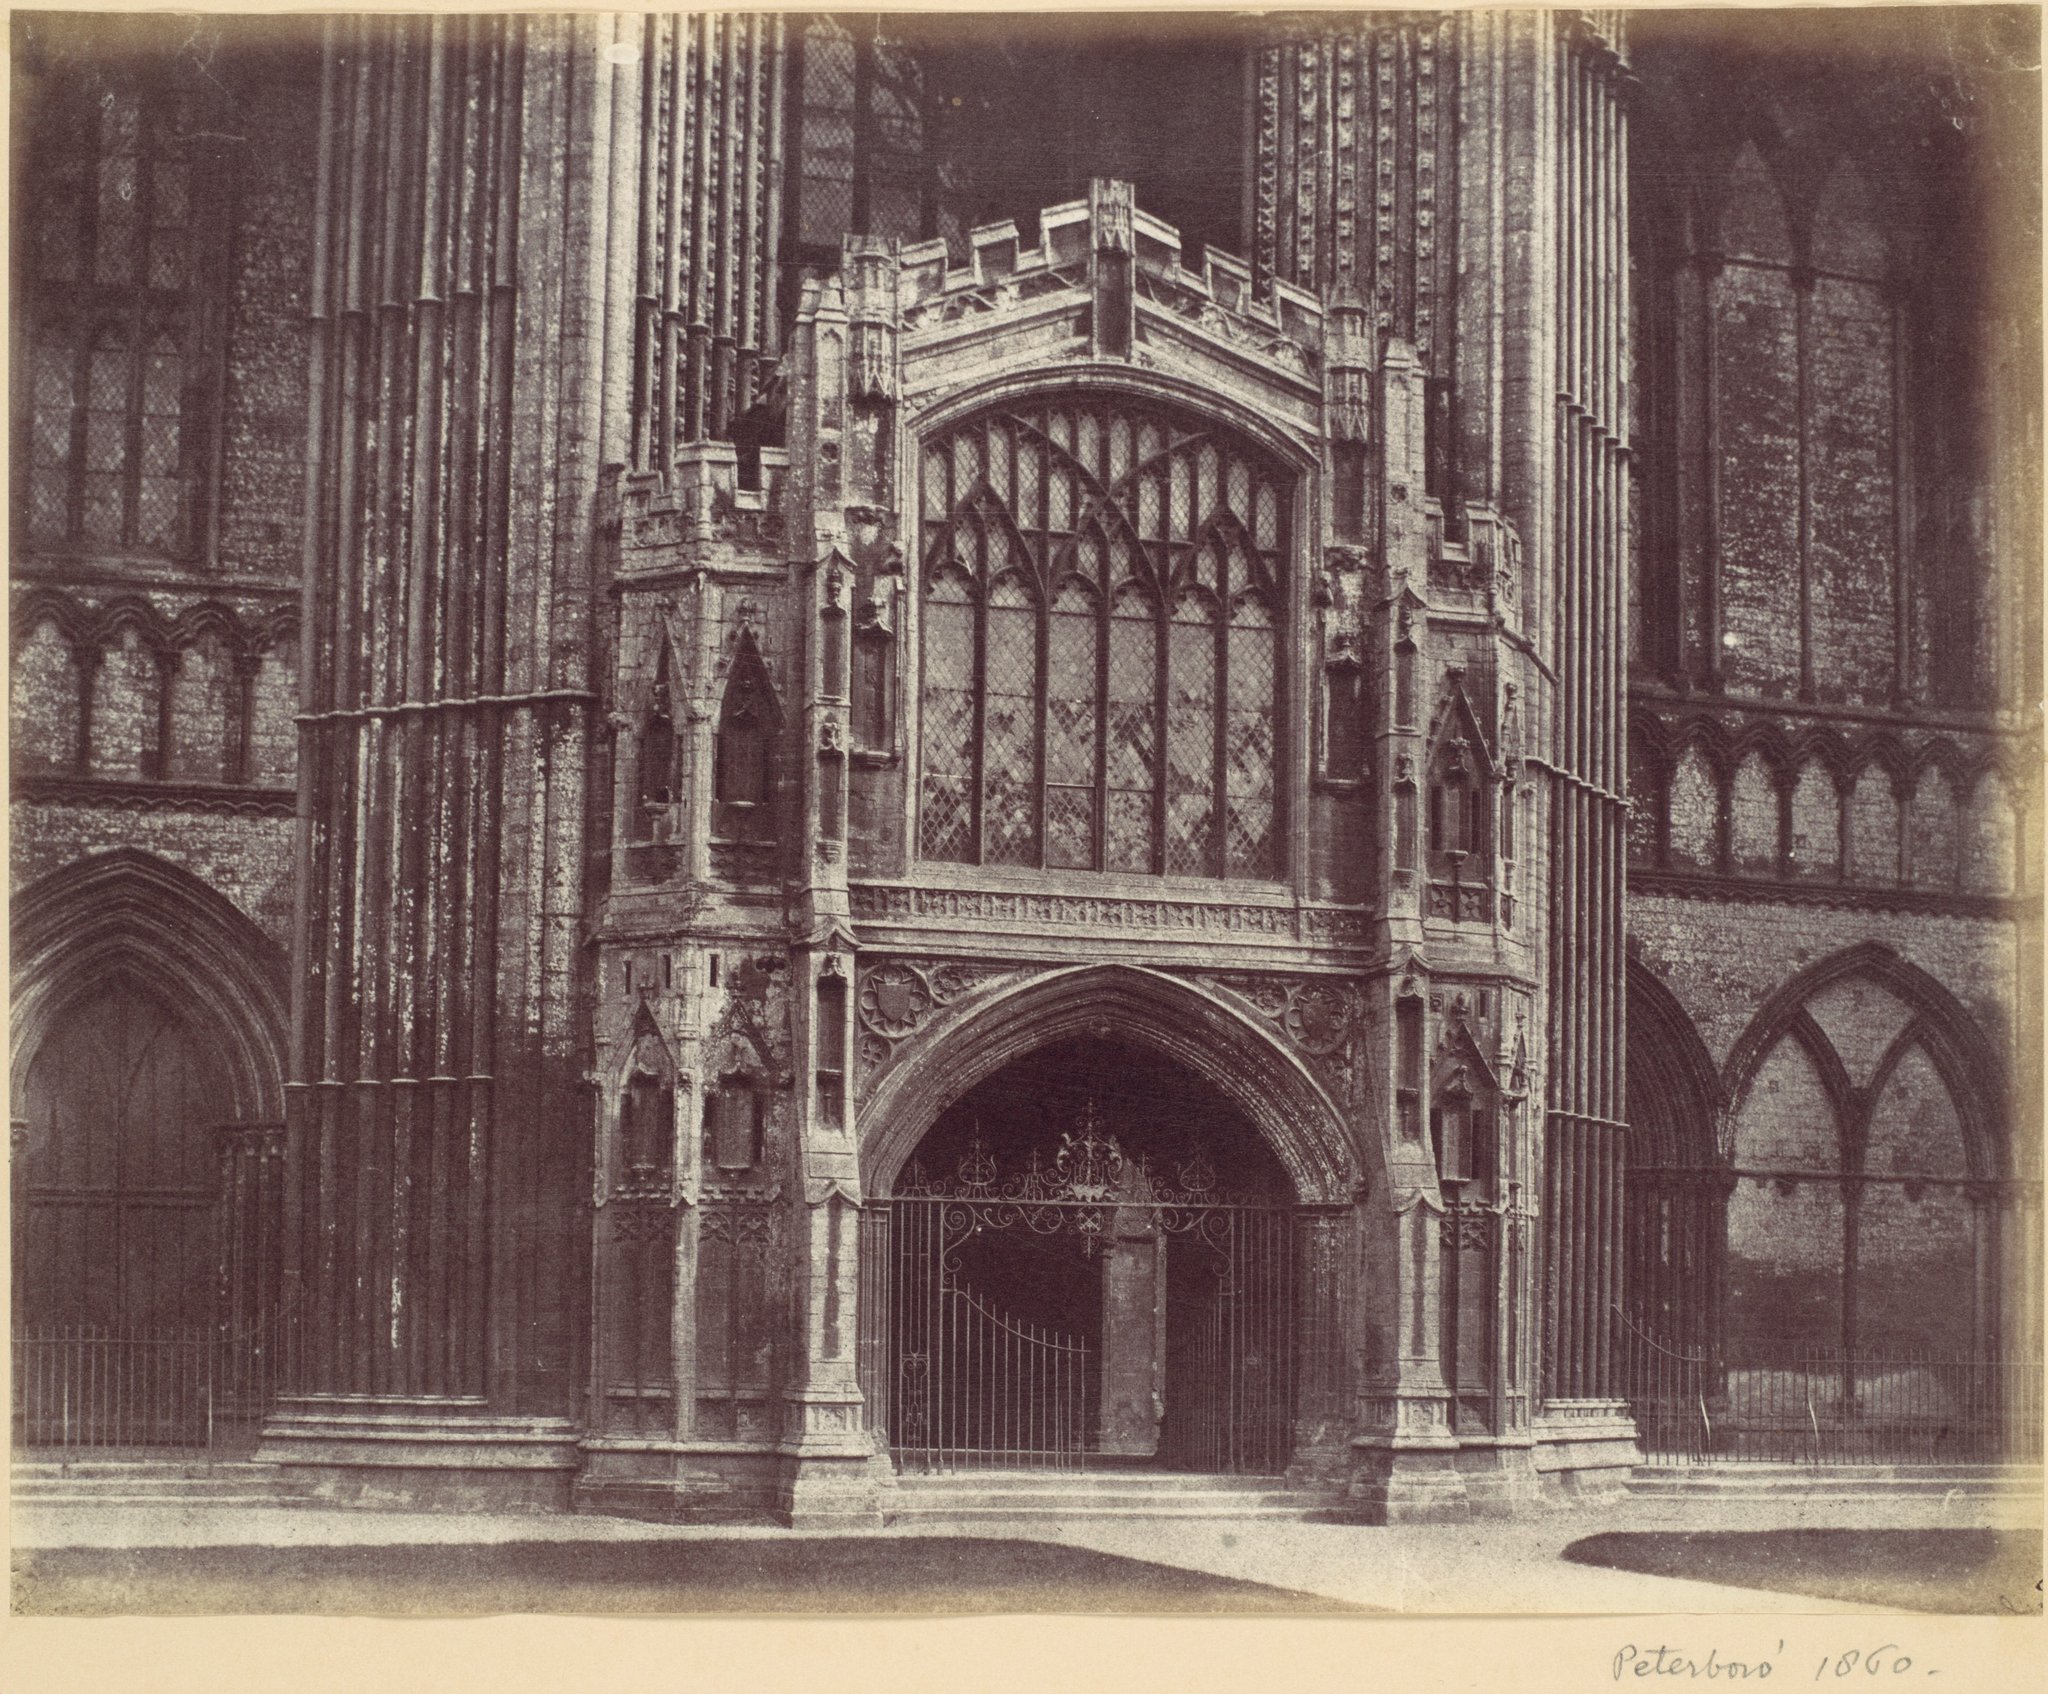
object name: photograph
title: Peterborough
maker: alfred capel cure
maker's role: artist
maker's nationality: british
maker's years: 1826-1896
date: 1860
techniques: albumen silver print, paper negative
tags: architecture,cathedrals